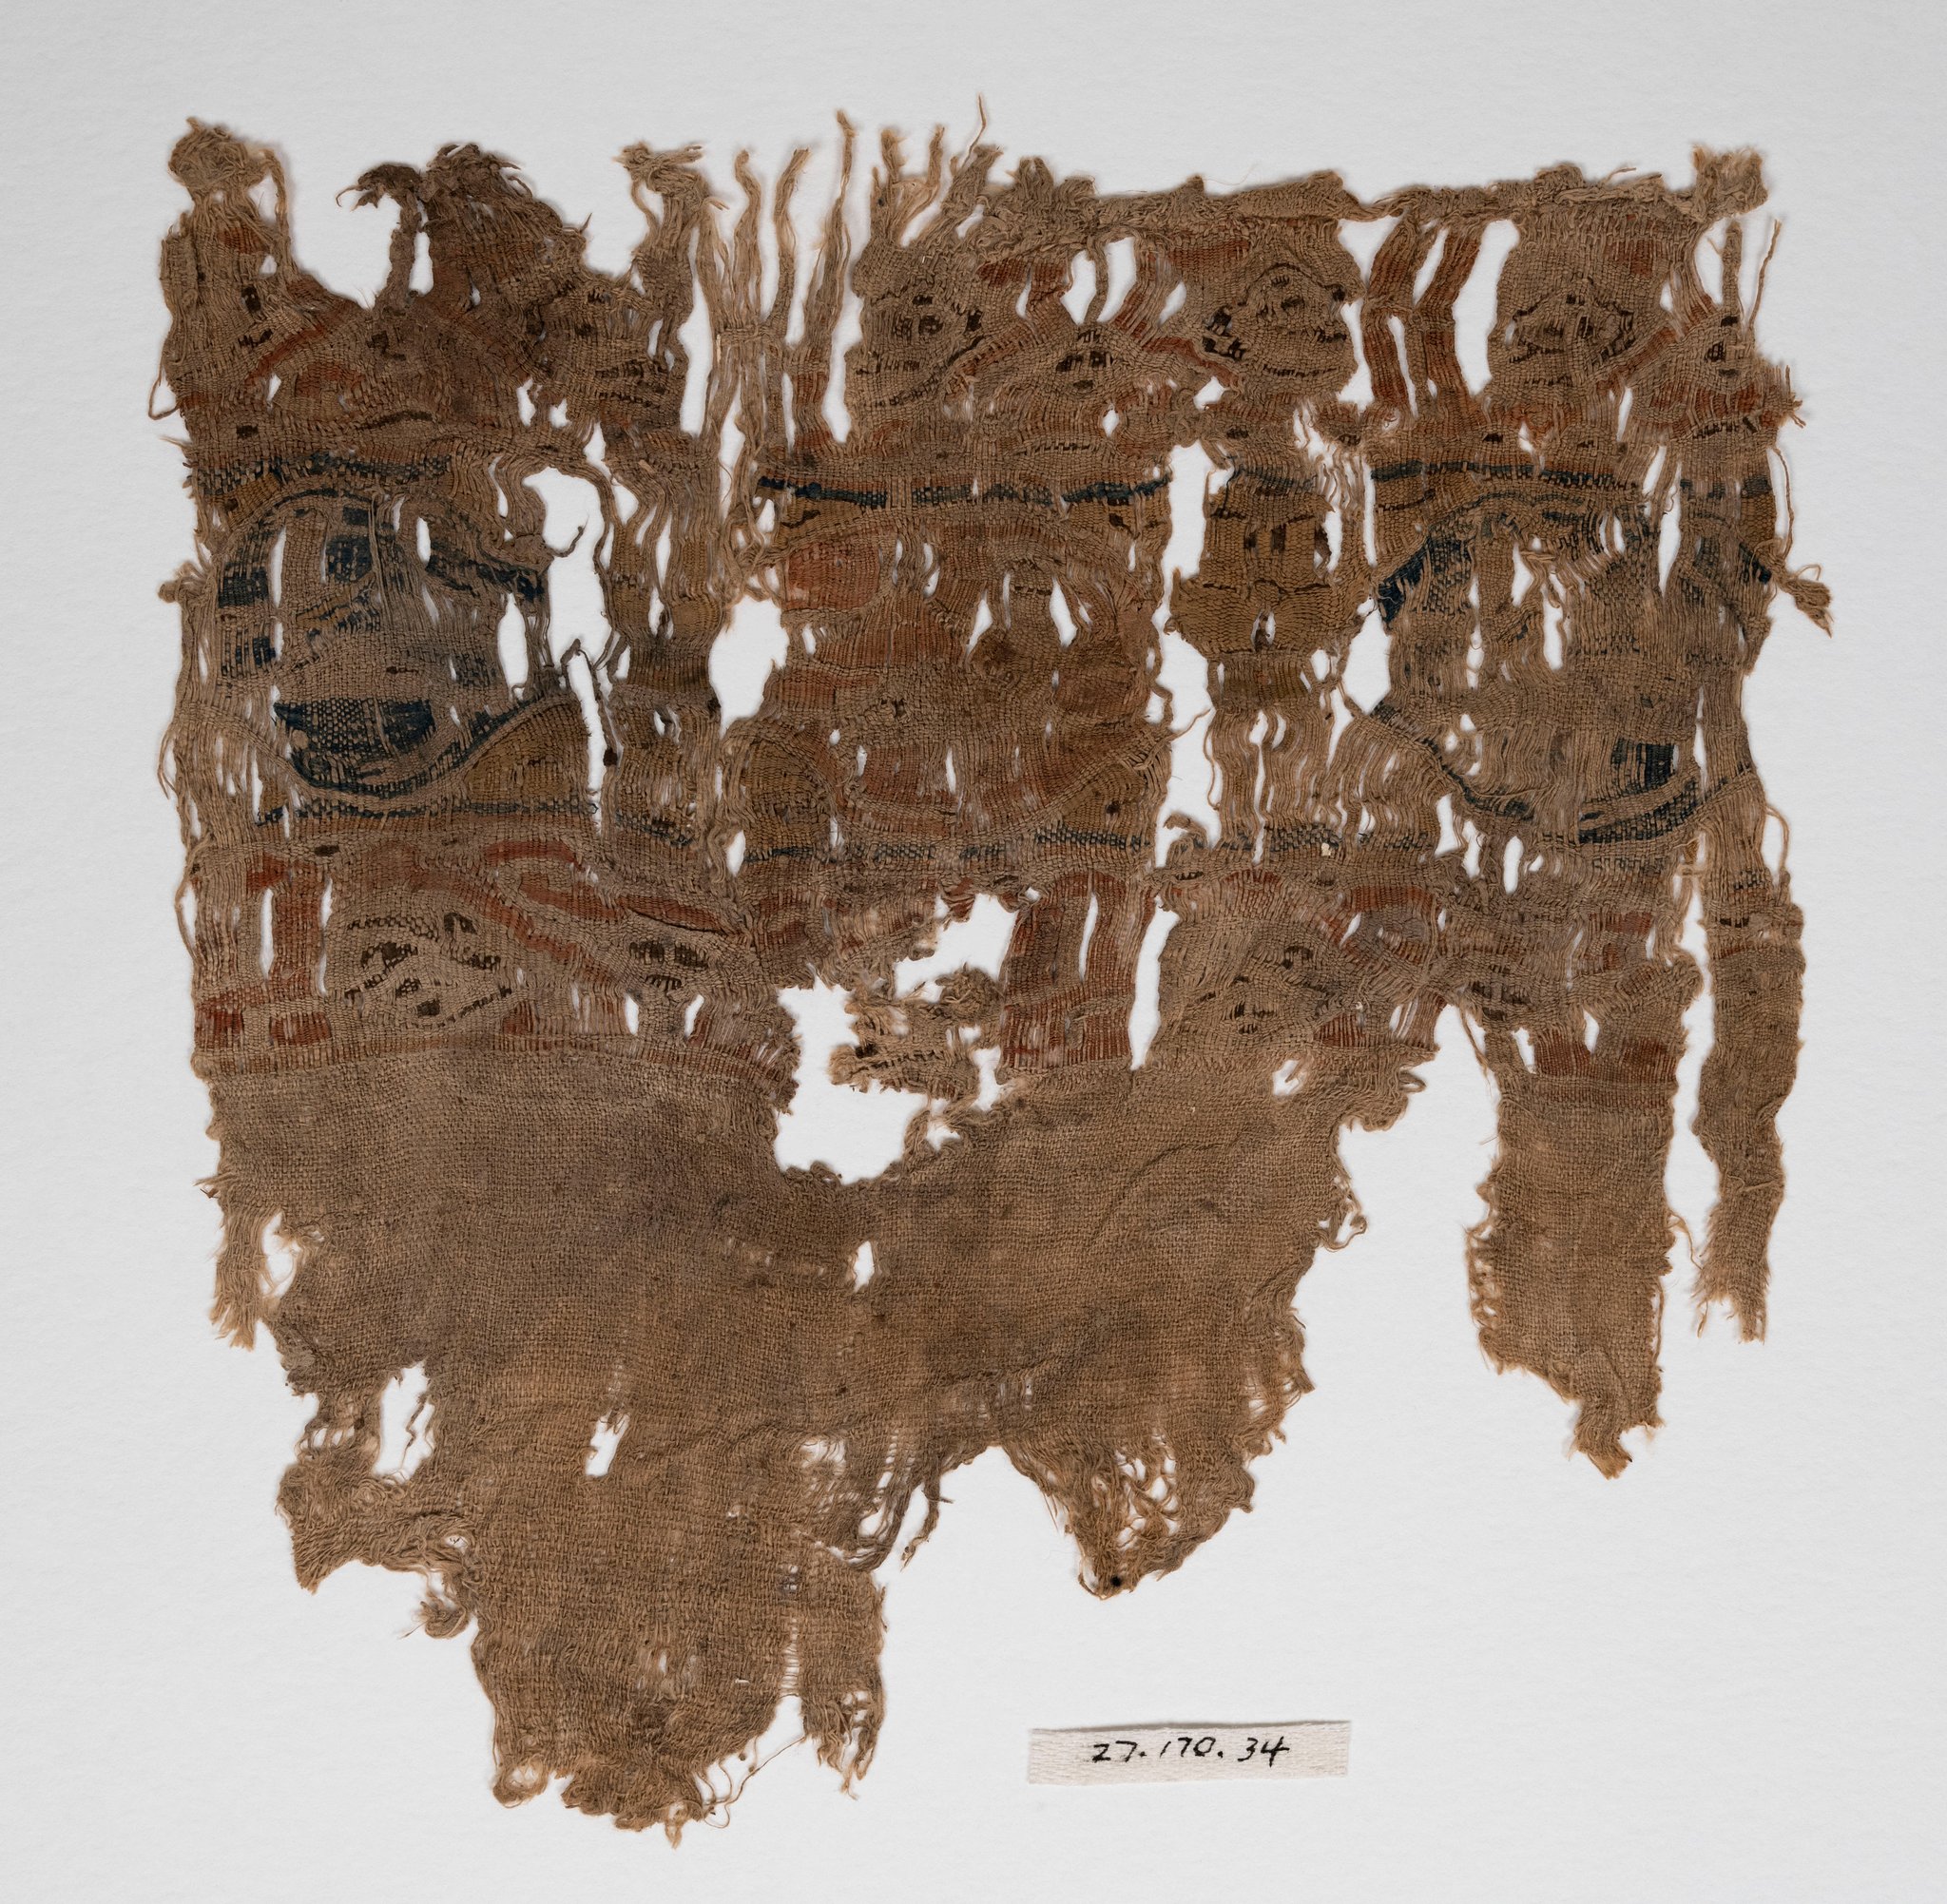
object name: textile fragment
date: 1001-1100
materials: linen, silk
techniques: tapestry, weave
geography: egypt